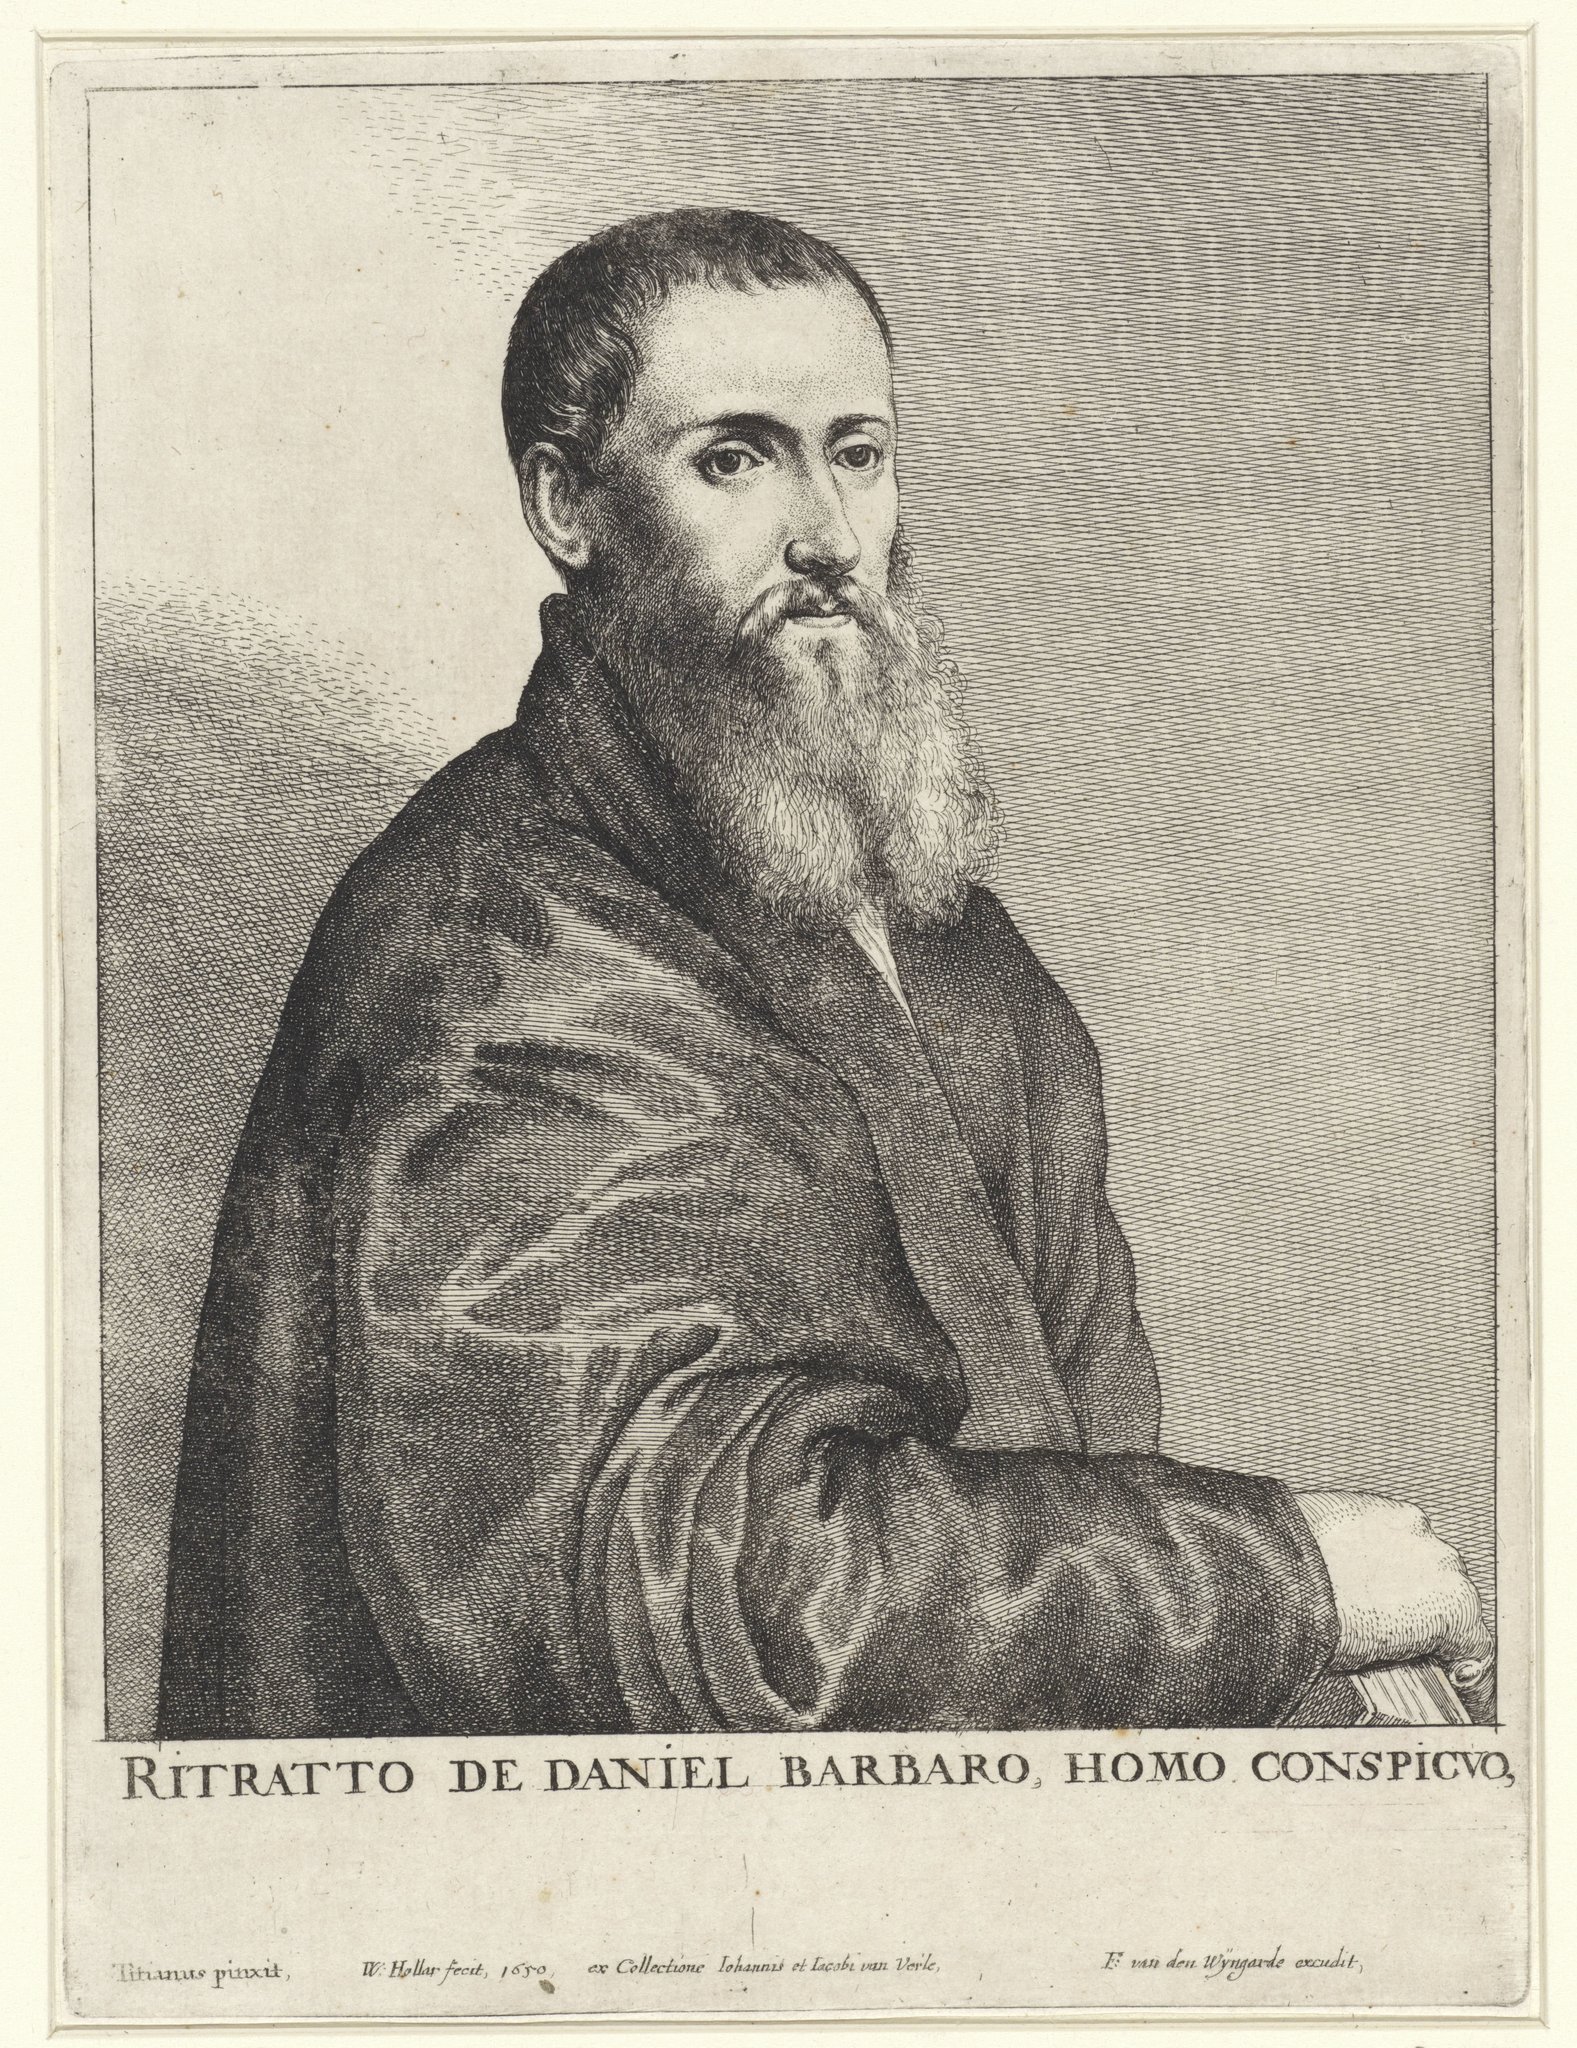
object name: print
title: Portret van Daniel Barbaro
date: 1649-1651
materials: paper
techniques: etching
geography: antwerp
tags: theoloog, daniele barbaro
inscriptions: collector's mark: Lugt 240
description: De prent maakt deel uit van een tiendelige serie met Italiaanse portretten (ongenummerd).